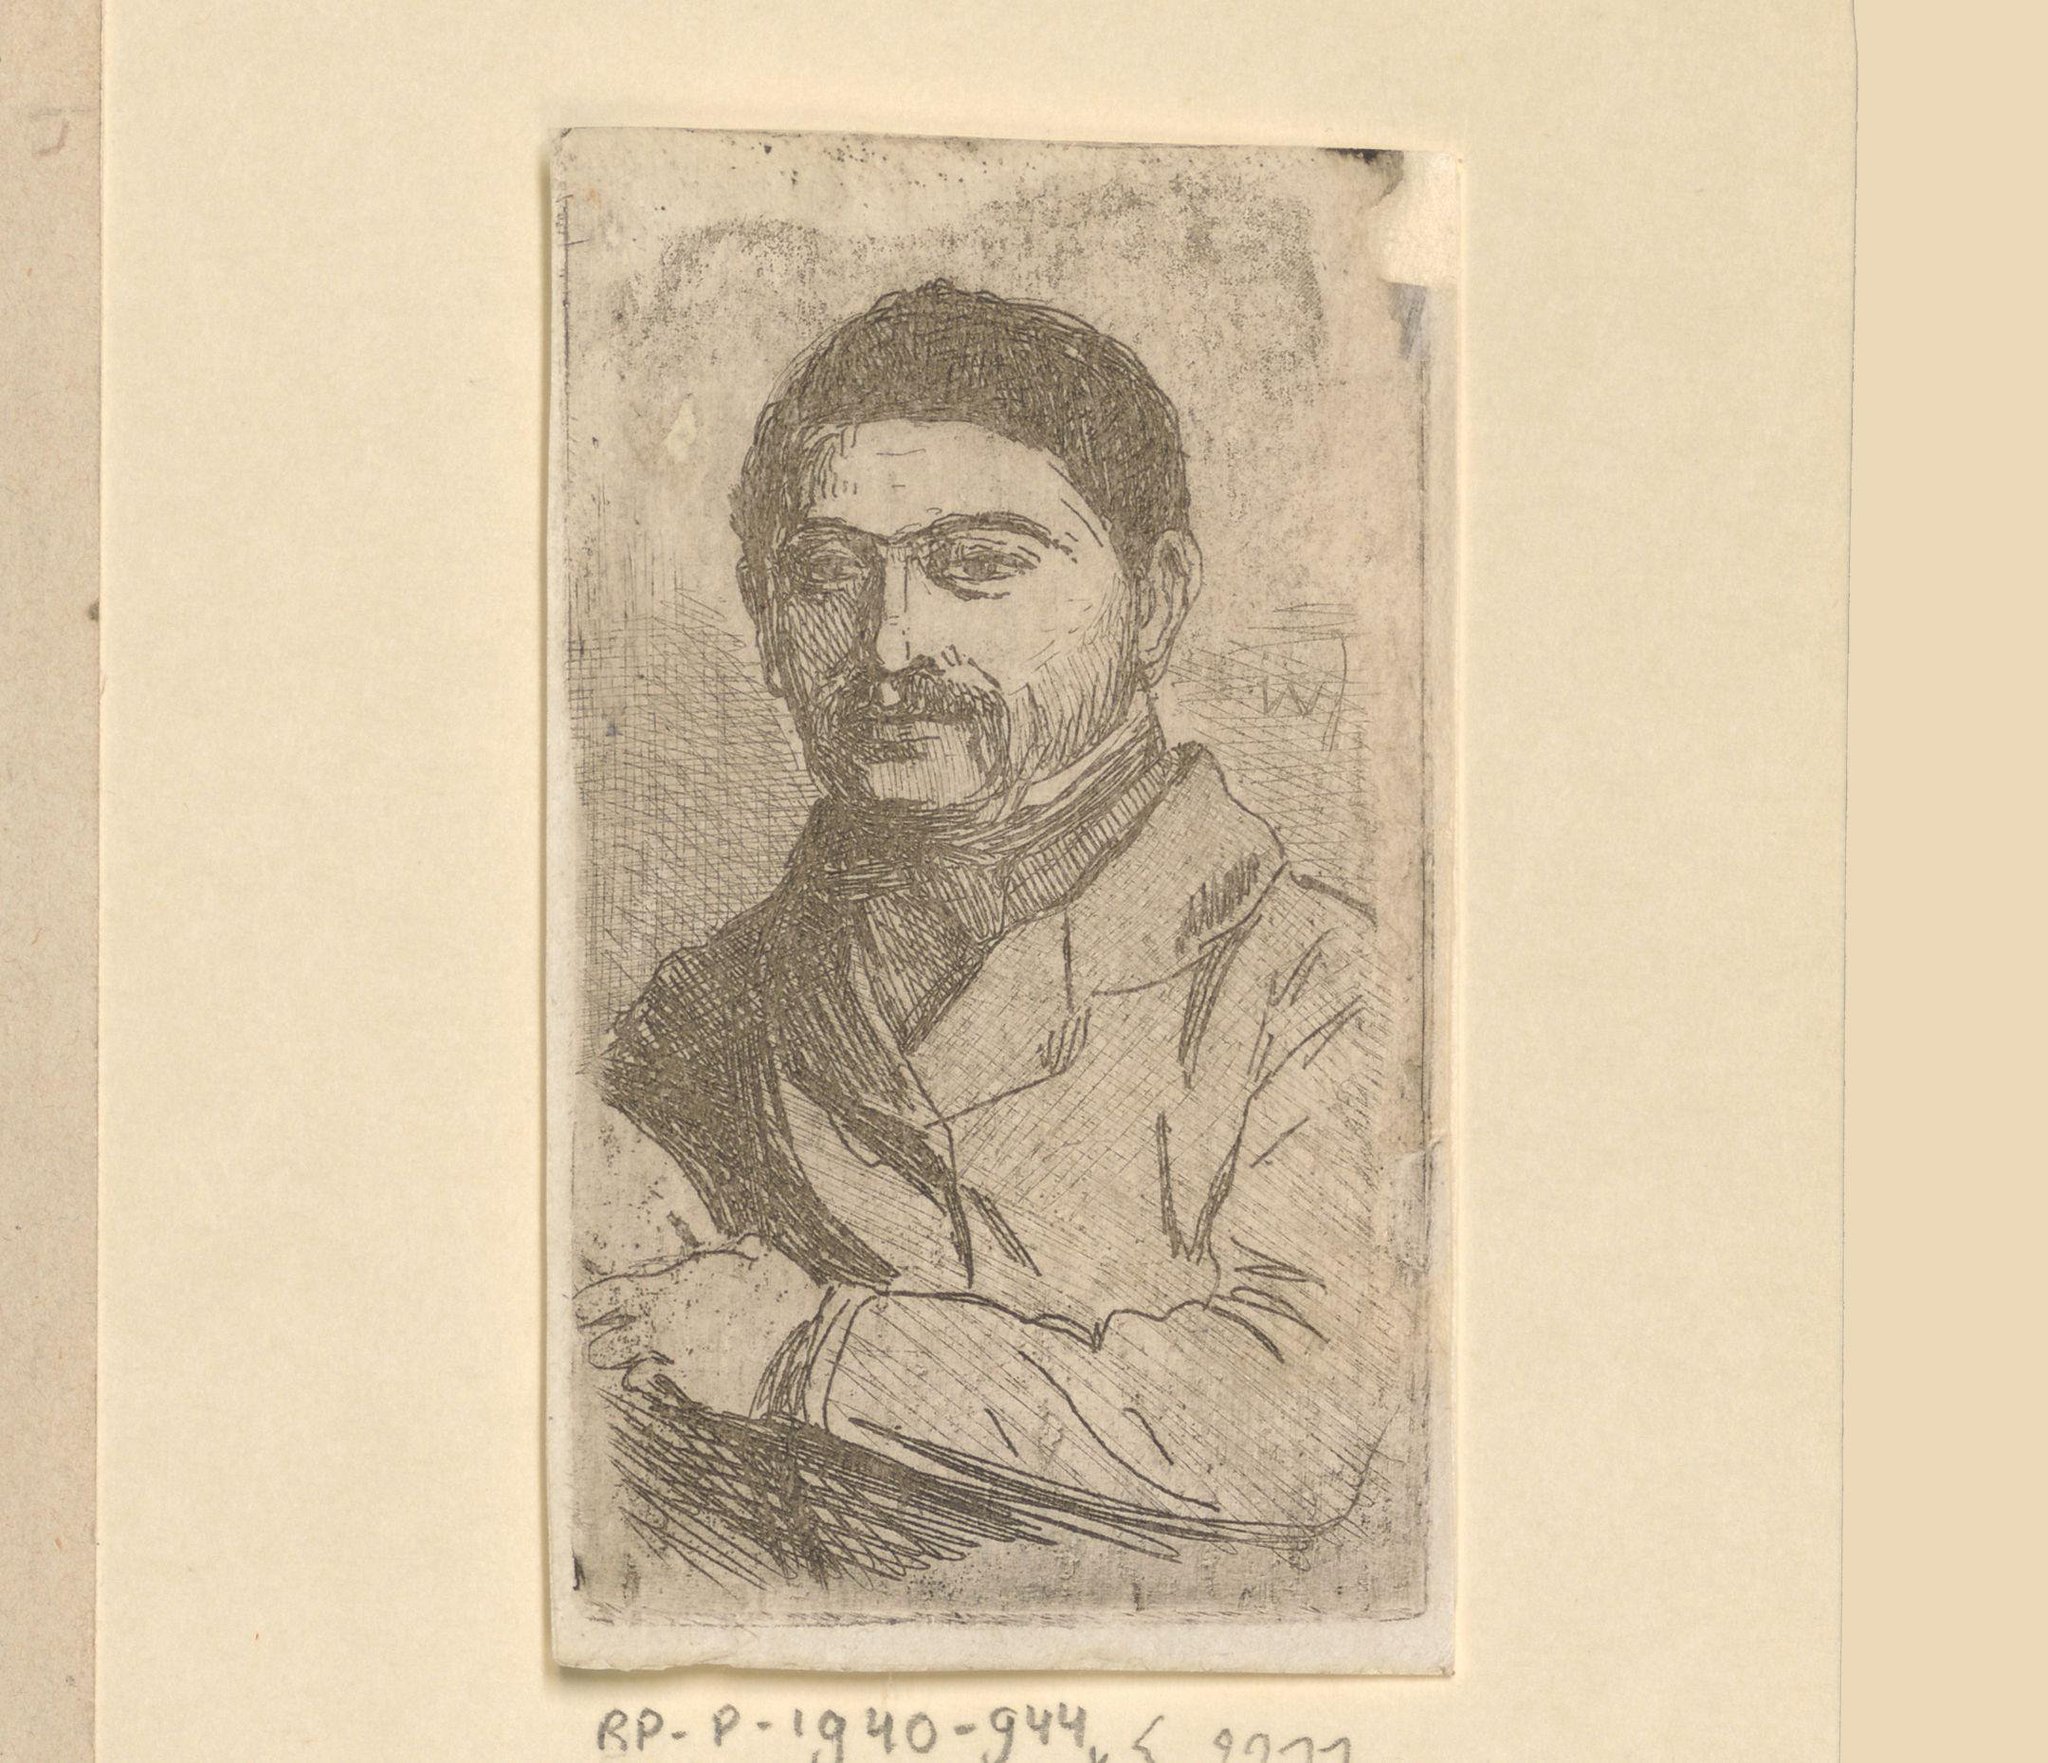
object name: print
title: Portret van Joseph Hartogensis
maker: jan weissenbruch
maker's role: painter, print maker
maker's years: 1822-1880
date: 1849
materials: paper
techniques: etching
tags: den bosch, joseph hartogensis, historical persons, portrait, self-portrait of artist